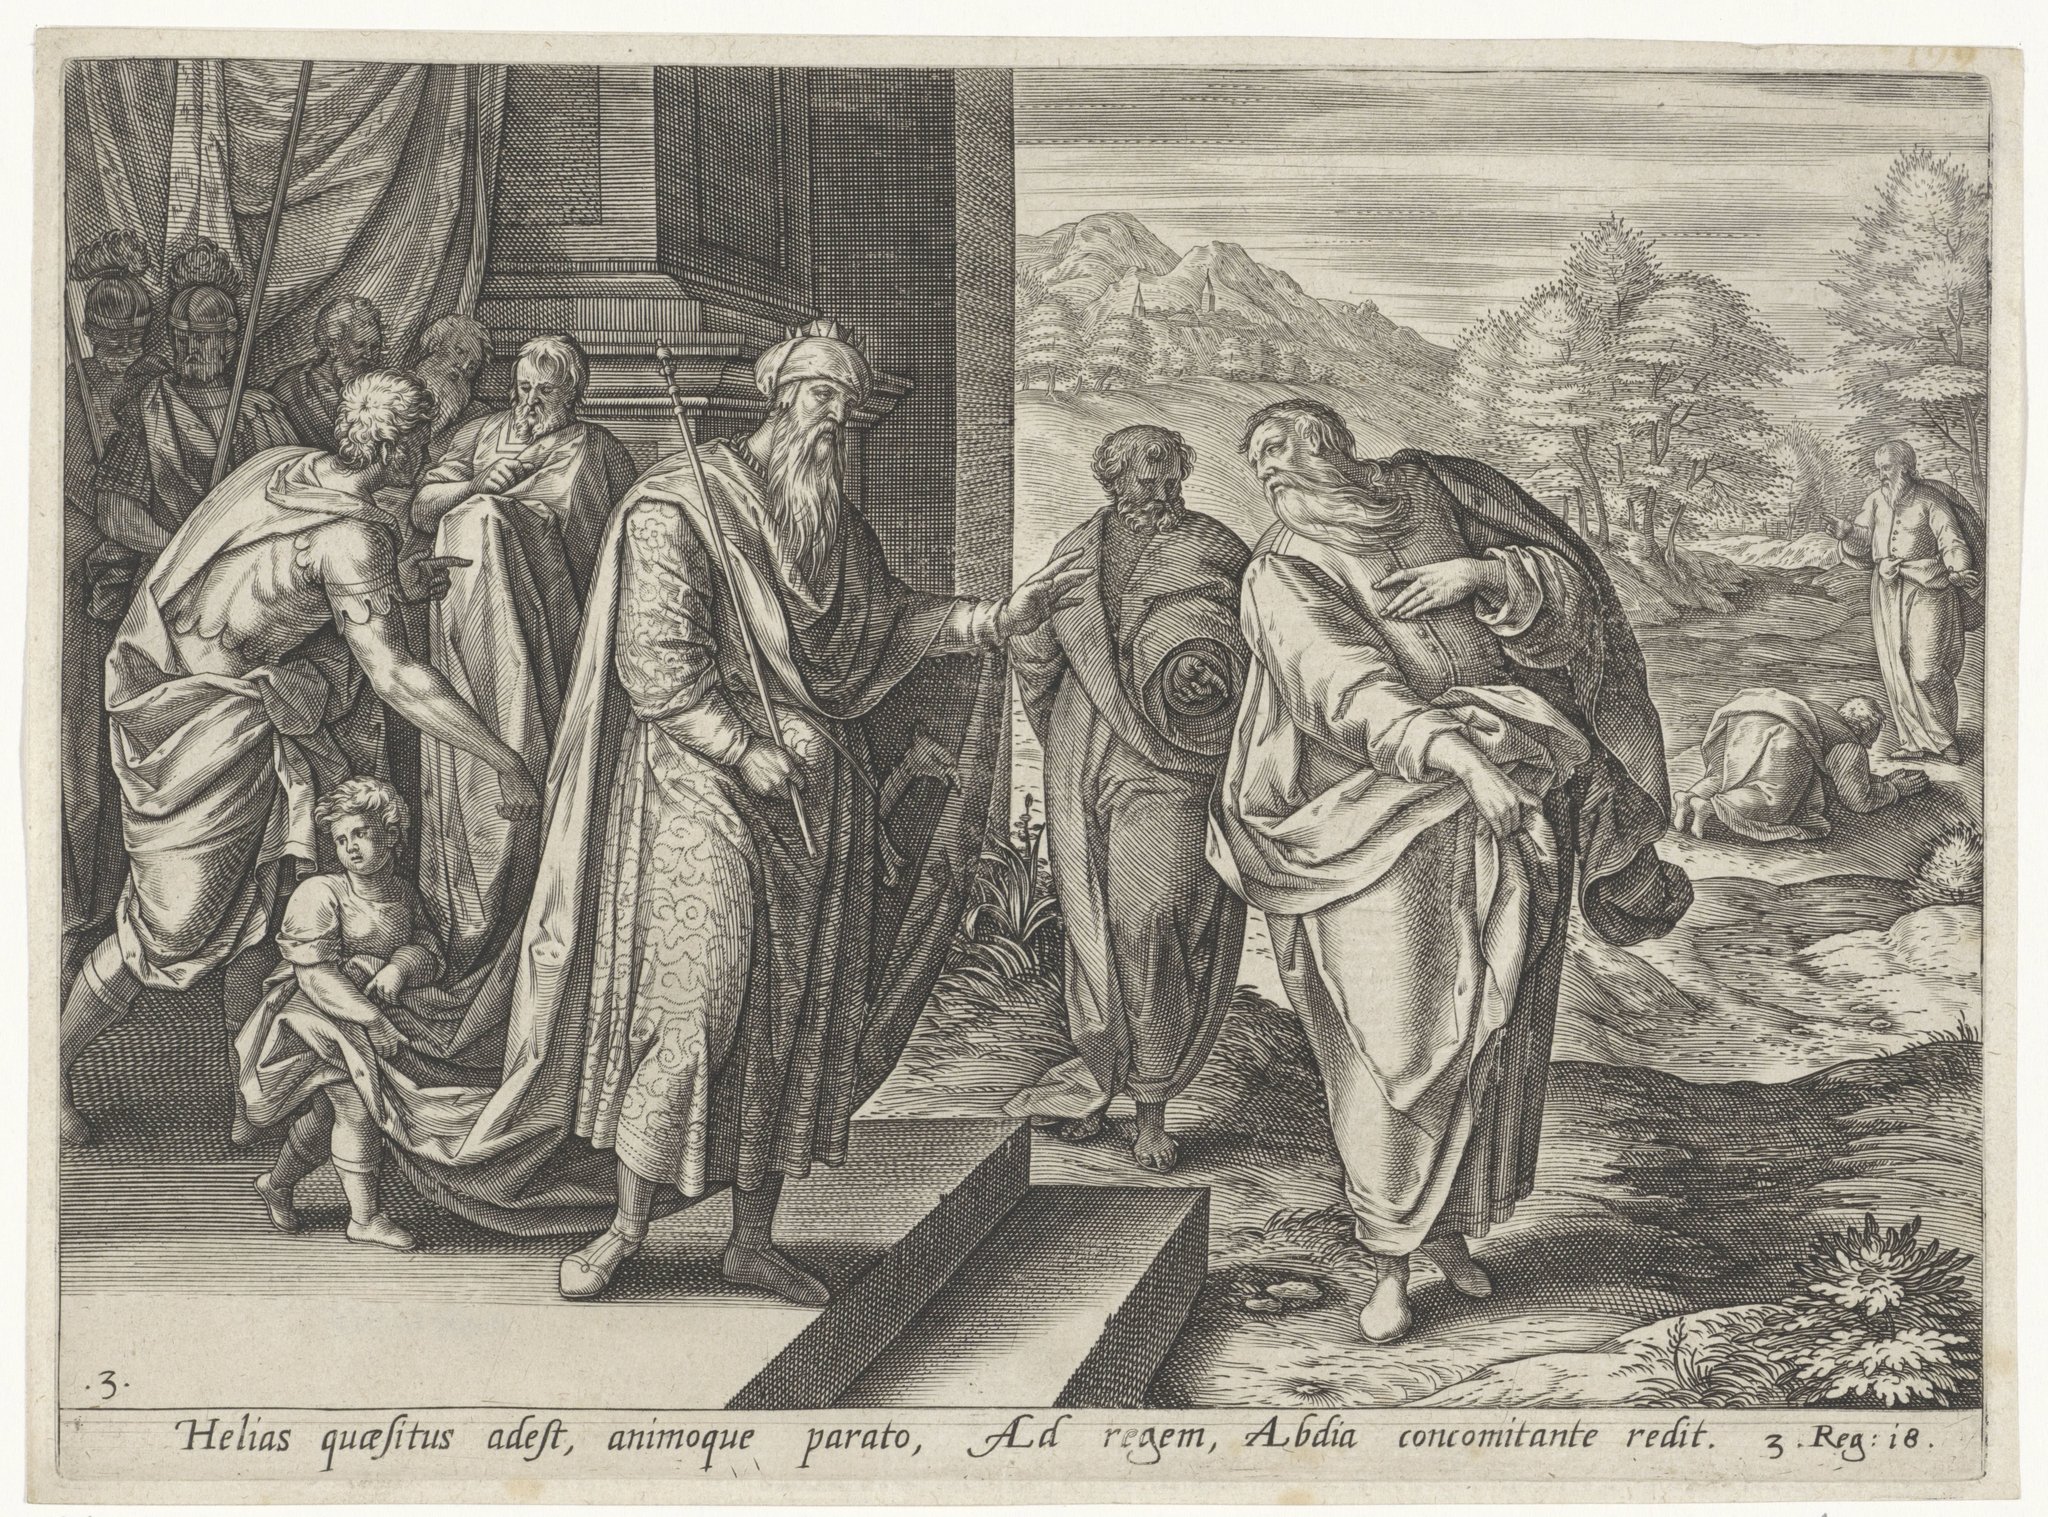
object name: print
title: Geschiedenis van Elia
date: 1579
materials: paper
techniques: engraving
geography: antwerp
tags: on his way obadiah meets elijah who commands him to summon the king, ahab is reproved by elijah and asked to gather the priests of baal on mount carmel for a contest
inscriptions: collector's mark: Lugt 2228, collector's mark: Lugt 2760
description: De profeet Elia is door Obadja, hofmeester van koning Achab, bij de koning gebracht; deze spreekt Elia aan met de woorden: 'Bent u het, Elia? U, die Israël in het ongeluk hebt gestort?'. Hierop legt Elia uit dat de koning zelf zijn volk in het ongeluk heeft gestort door de verkeerde goden te vereren. Op de achtergrond rechts is te zien hoe Obadja, zodra hij Elia herkende, voor hem boog. Onder de voorstelling een verwijzing in het Latijn naar de Bijbeltekst in 1 Kon. 18.